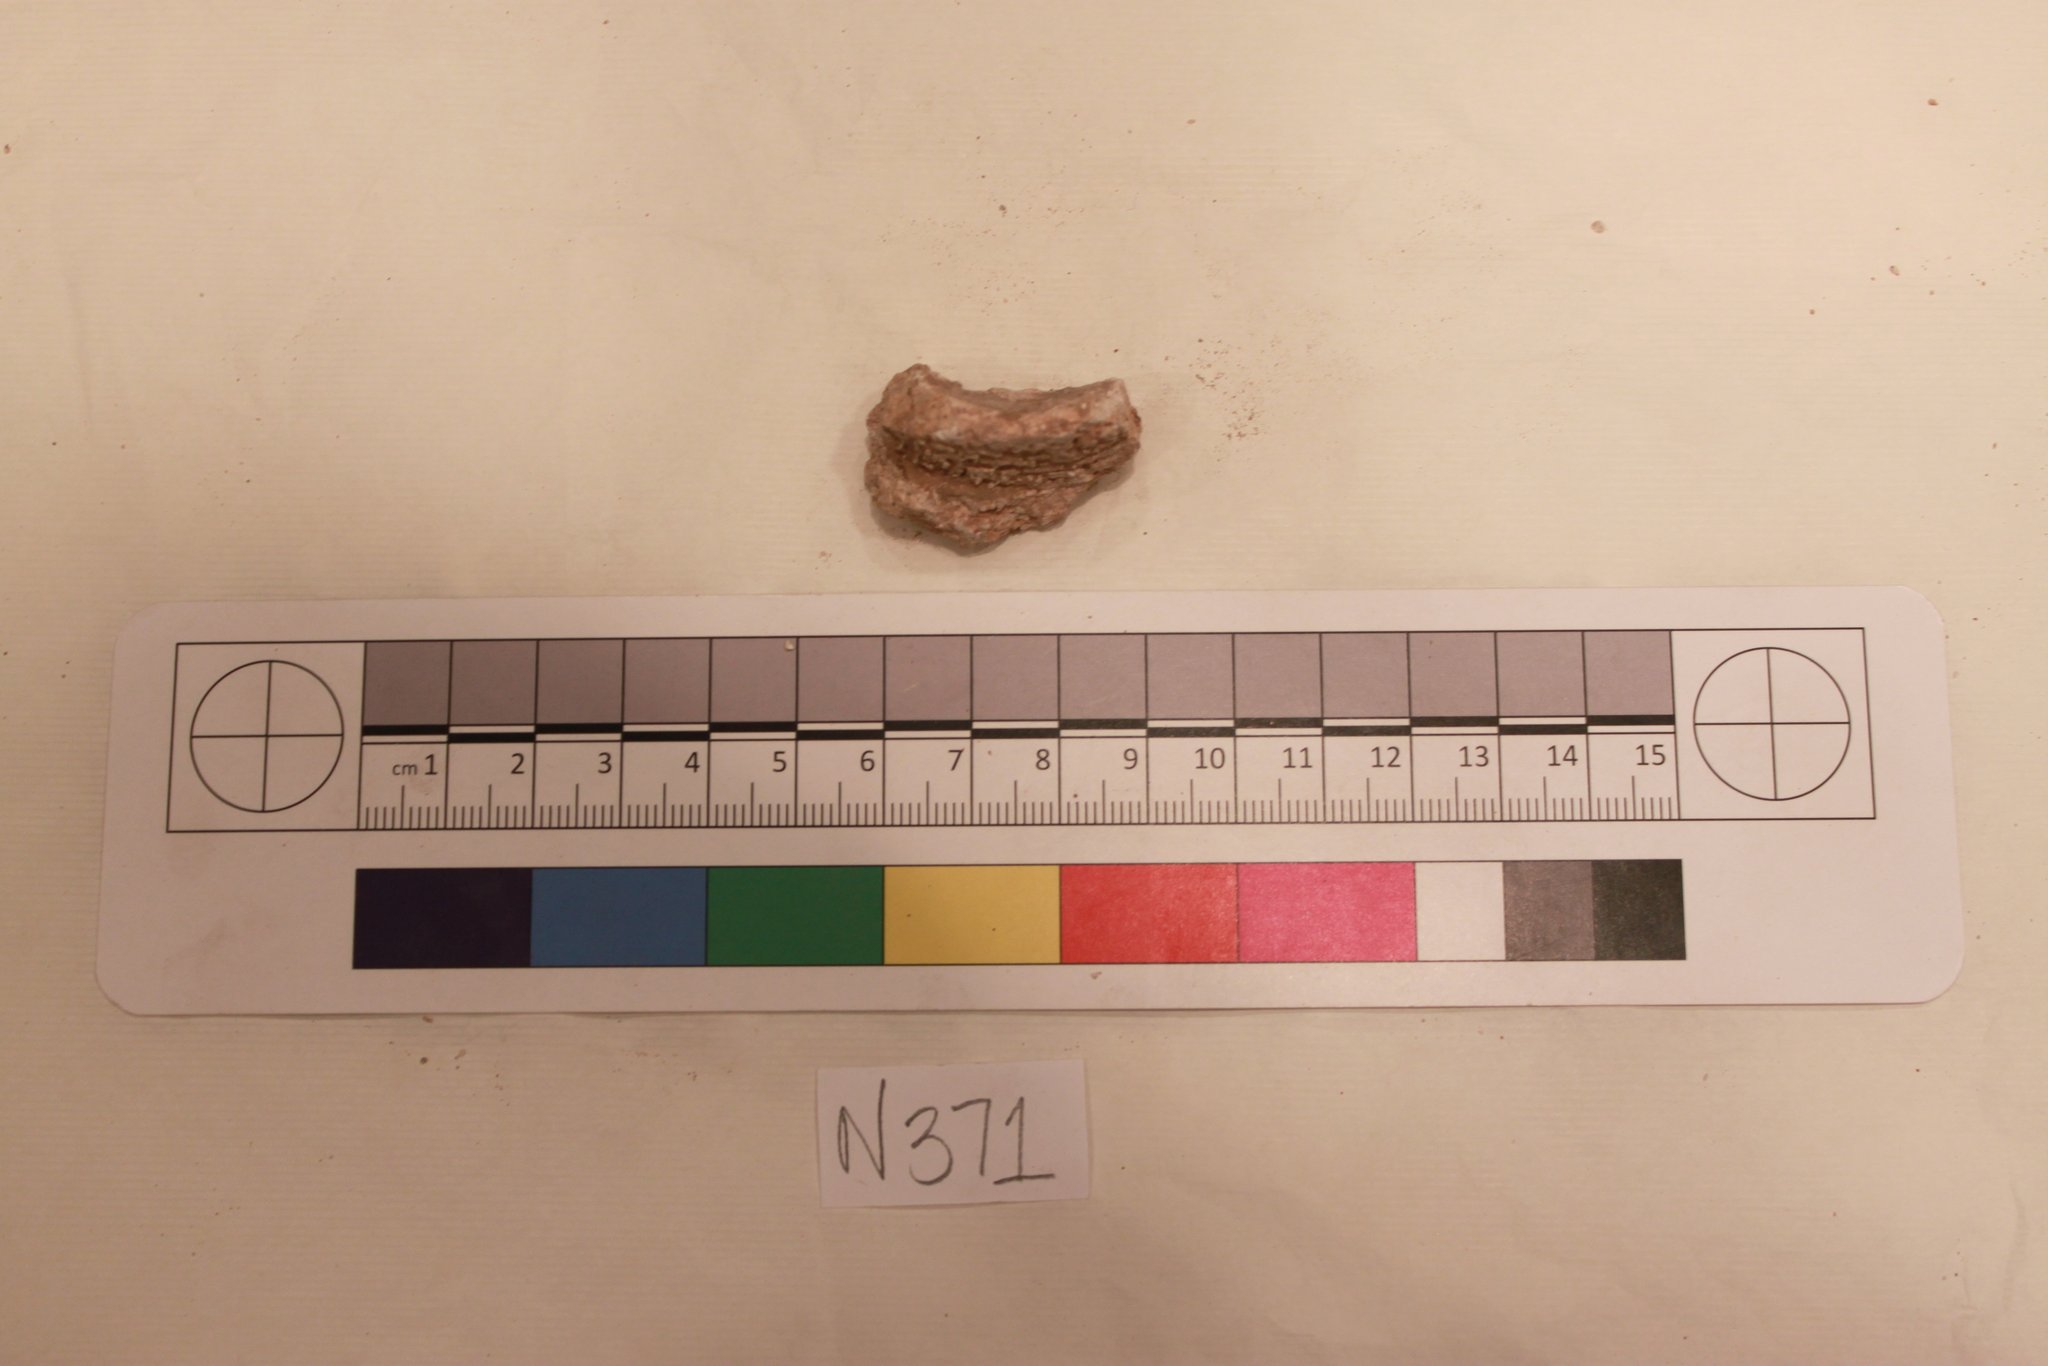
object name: fragment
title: Stucco Fragment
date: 701-1200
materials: plaster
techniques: carving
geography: iran